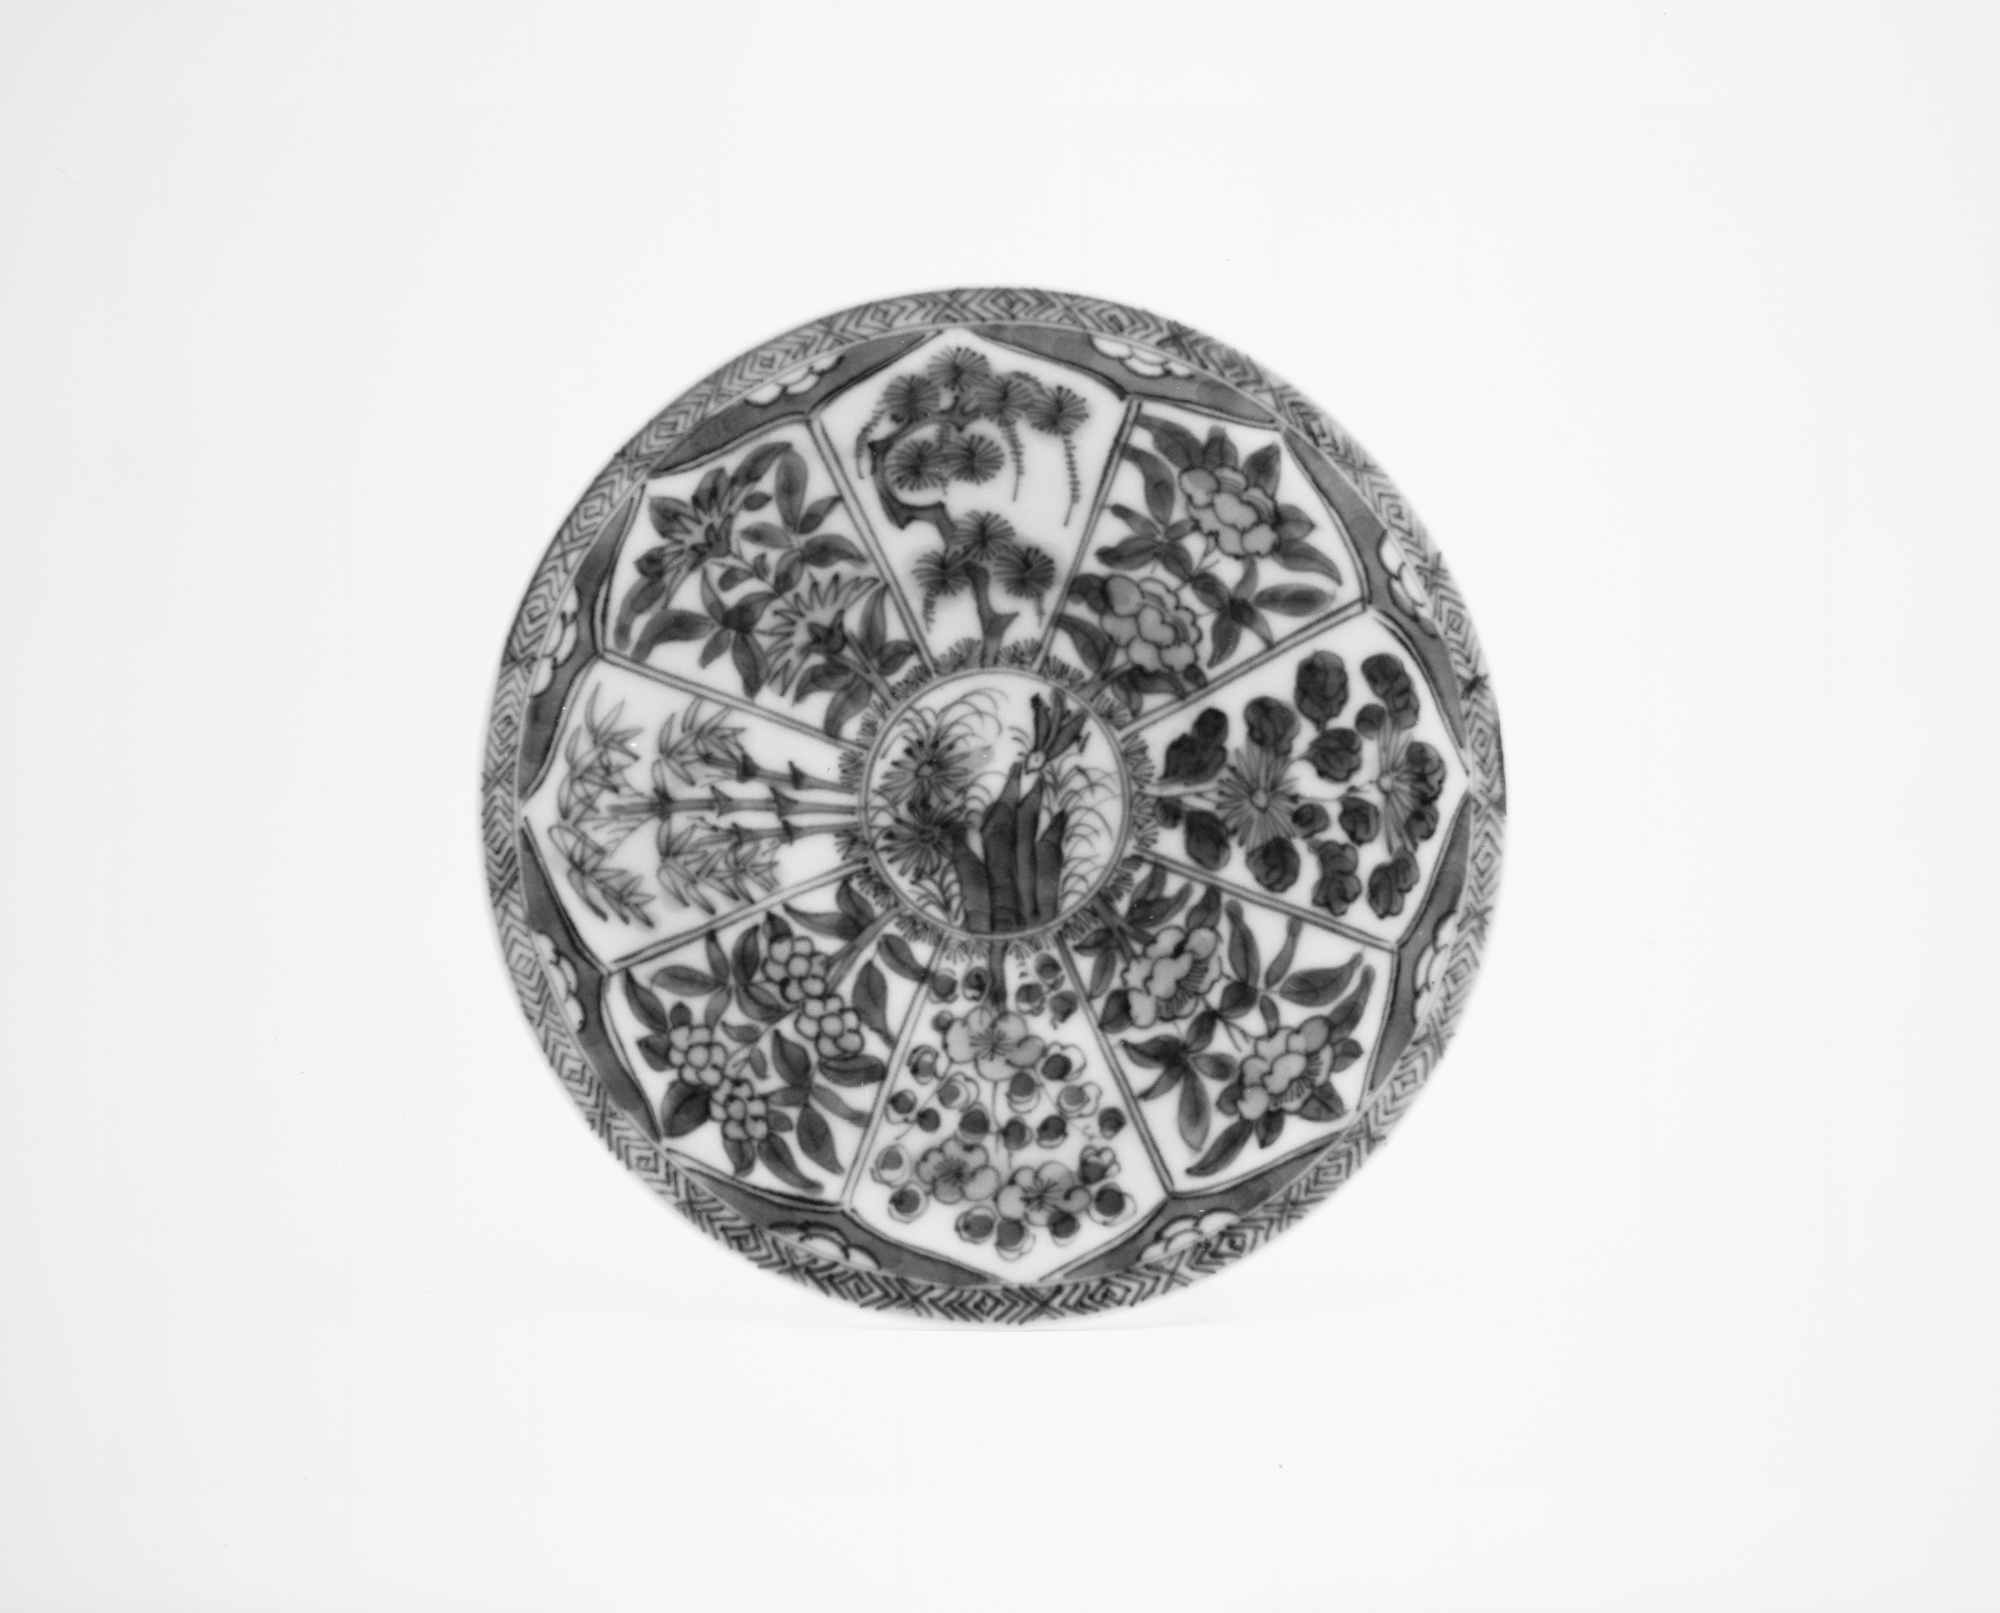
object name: saucer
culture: japanese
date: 1840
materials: glaze, porcelain